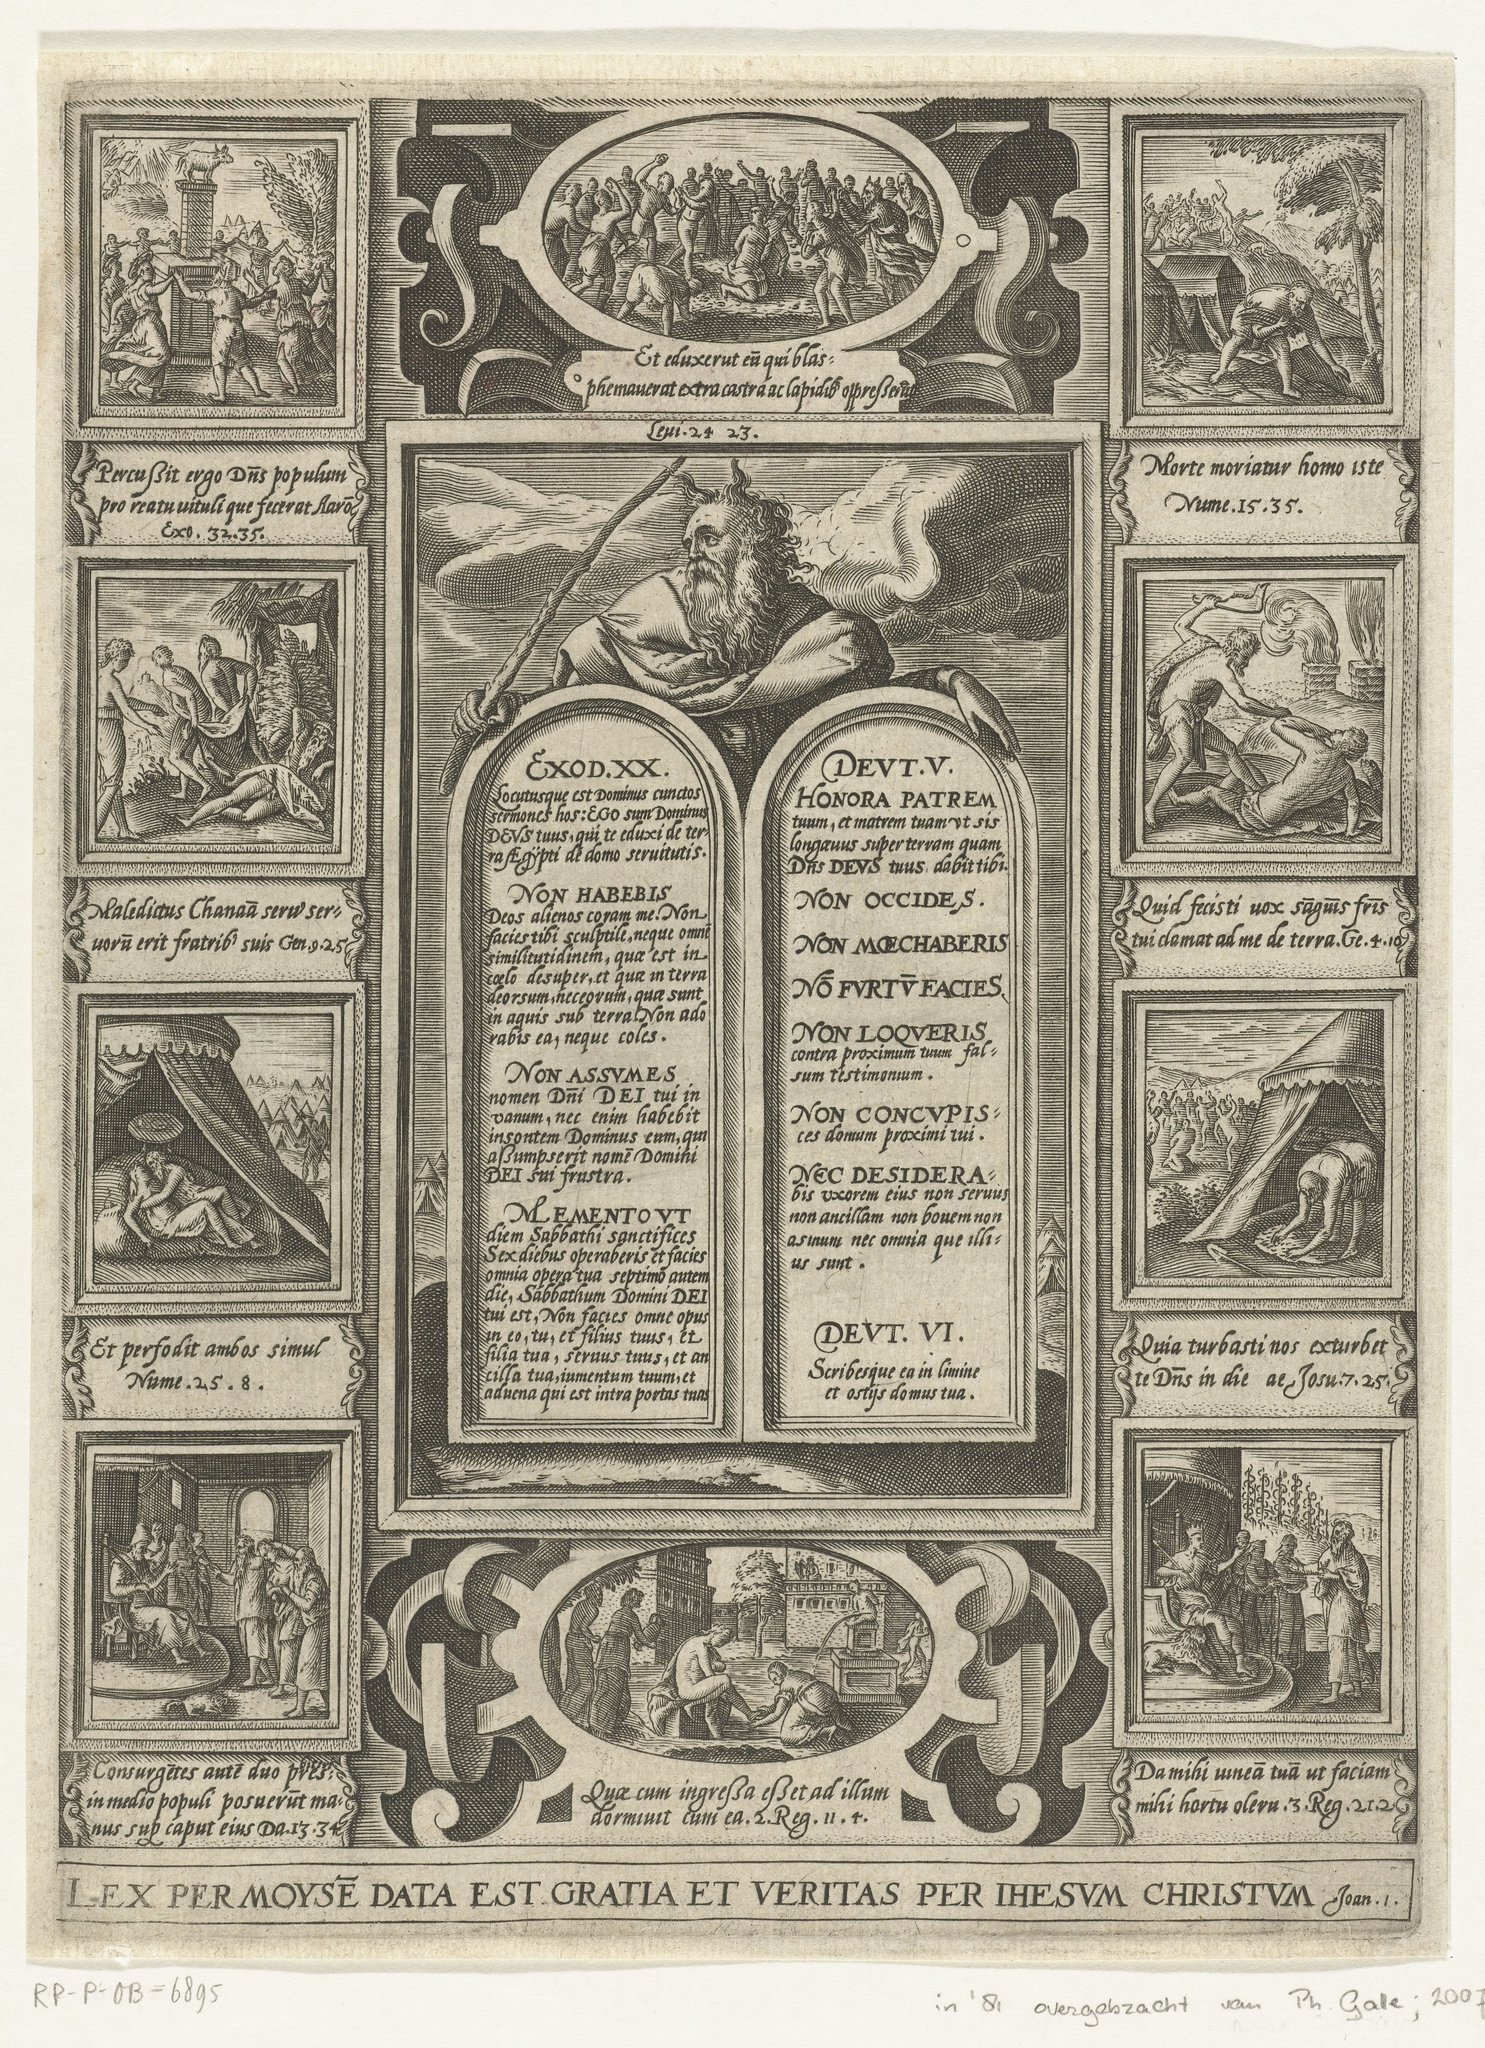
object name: print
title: Mozes met de tafelen der wet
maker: Anonymous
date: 1575-1585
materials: paper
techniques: engraving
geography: low countries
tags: moses (not in biblical context); possible attributes: rays of light or horns on his head, rod, tables of the law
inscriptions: collector's mark: Lugt 2228a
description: Mozes met een staf en de tafelen der wet in omlijsting, waaromheen tien scènes en teksten uit het Oude Testament, ter illustratie van de tien geboden.